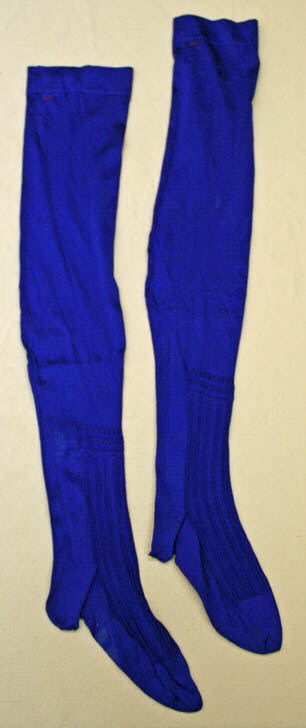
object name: stocking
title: Stockings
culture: french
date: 1900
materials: silk